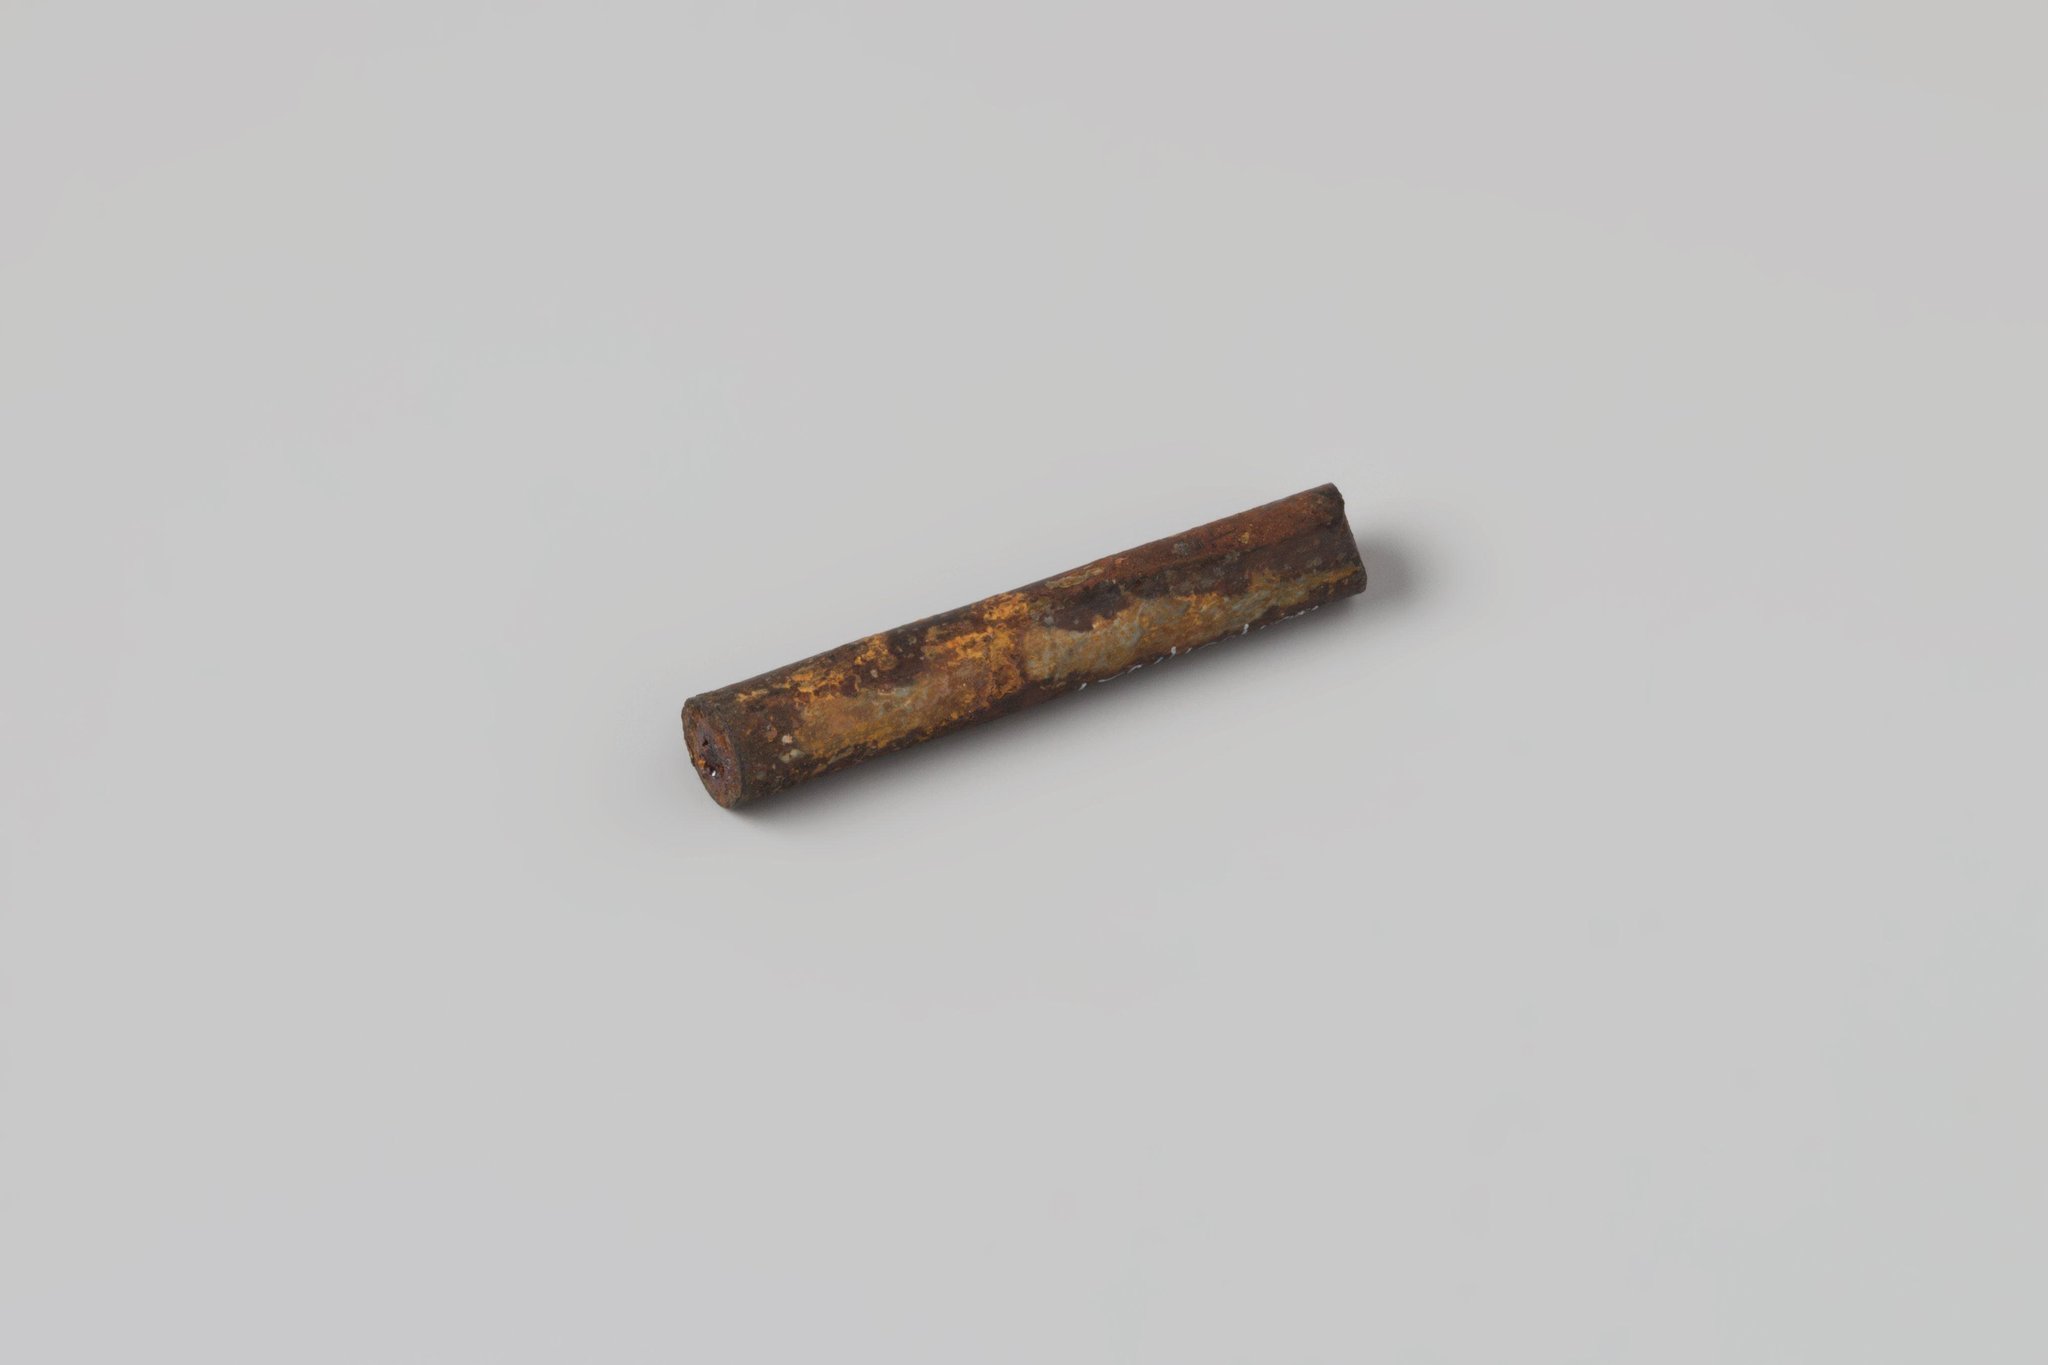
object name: pipe stem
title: Fragment pijpensteel uit het wrak van de Oost-Indiëvaarder Hollandia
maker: Anonymous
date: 1700-1743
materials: clay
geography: netherlands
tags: verenigde oostindische compagnie, hollandia (schip), annet